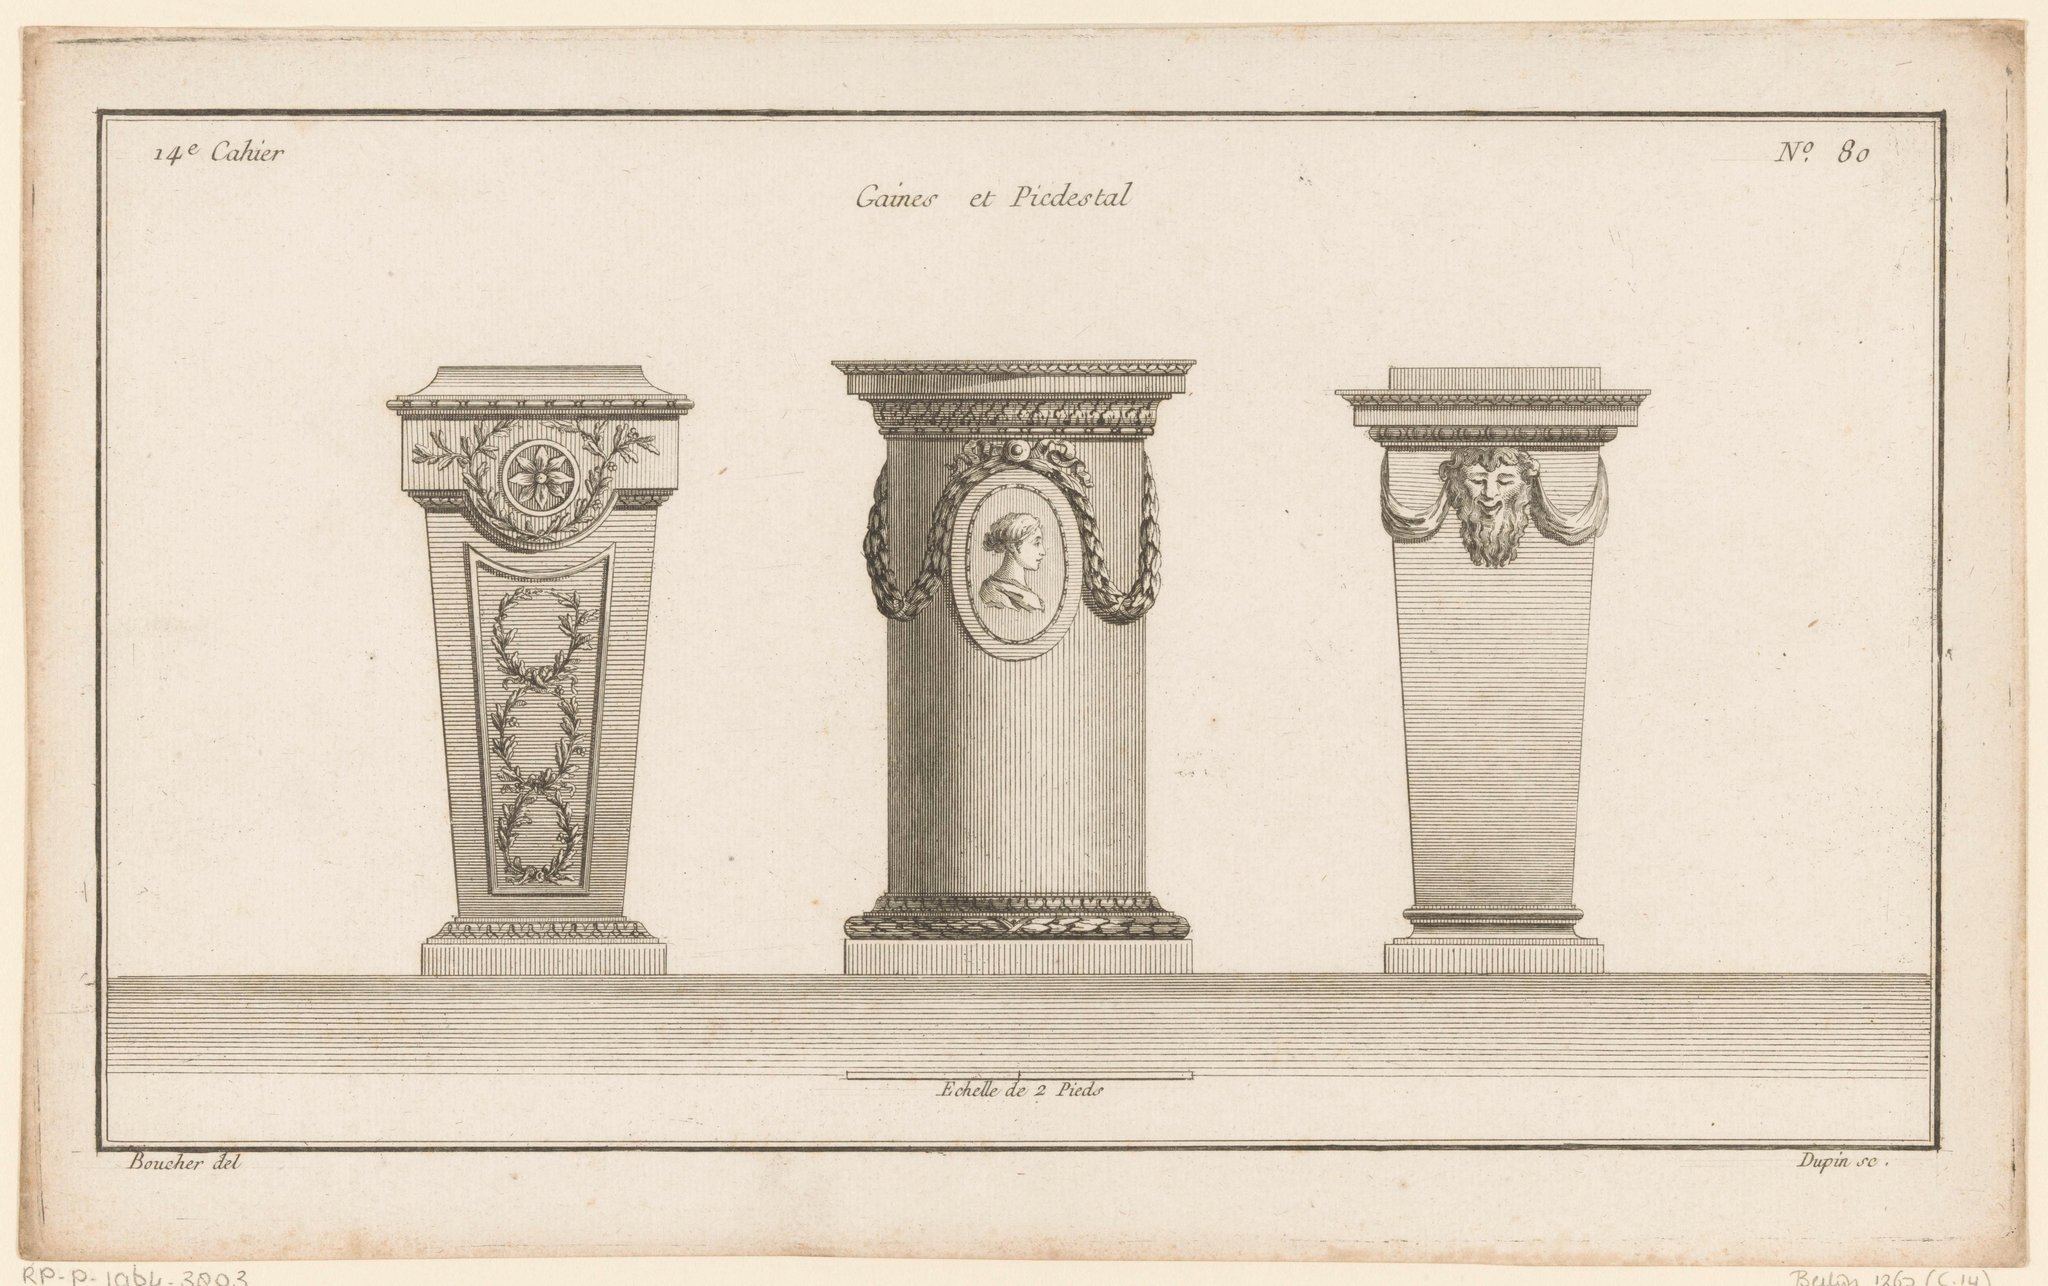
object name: ornament print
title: 14e Cahier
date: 1772-1779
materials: paper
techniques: engraving, etching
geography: paris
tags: ornament ~ medallion, pedestal of a piece of sculpture (perhaps in the form of a herm), mask, mascaron ~ ornament, ornament ~ festoon, garland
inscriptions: collector's mark: Lugt 2228, collector's mark: Lugt 2760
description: Twee geornamenteerde voetstukken en een zuil met guirlandes. Links met bloemmotief en ranken, in het midden met vrouwenportret in medaillon en rechts met mannelijk gezicht. Prentnummer 80.